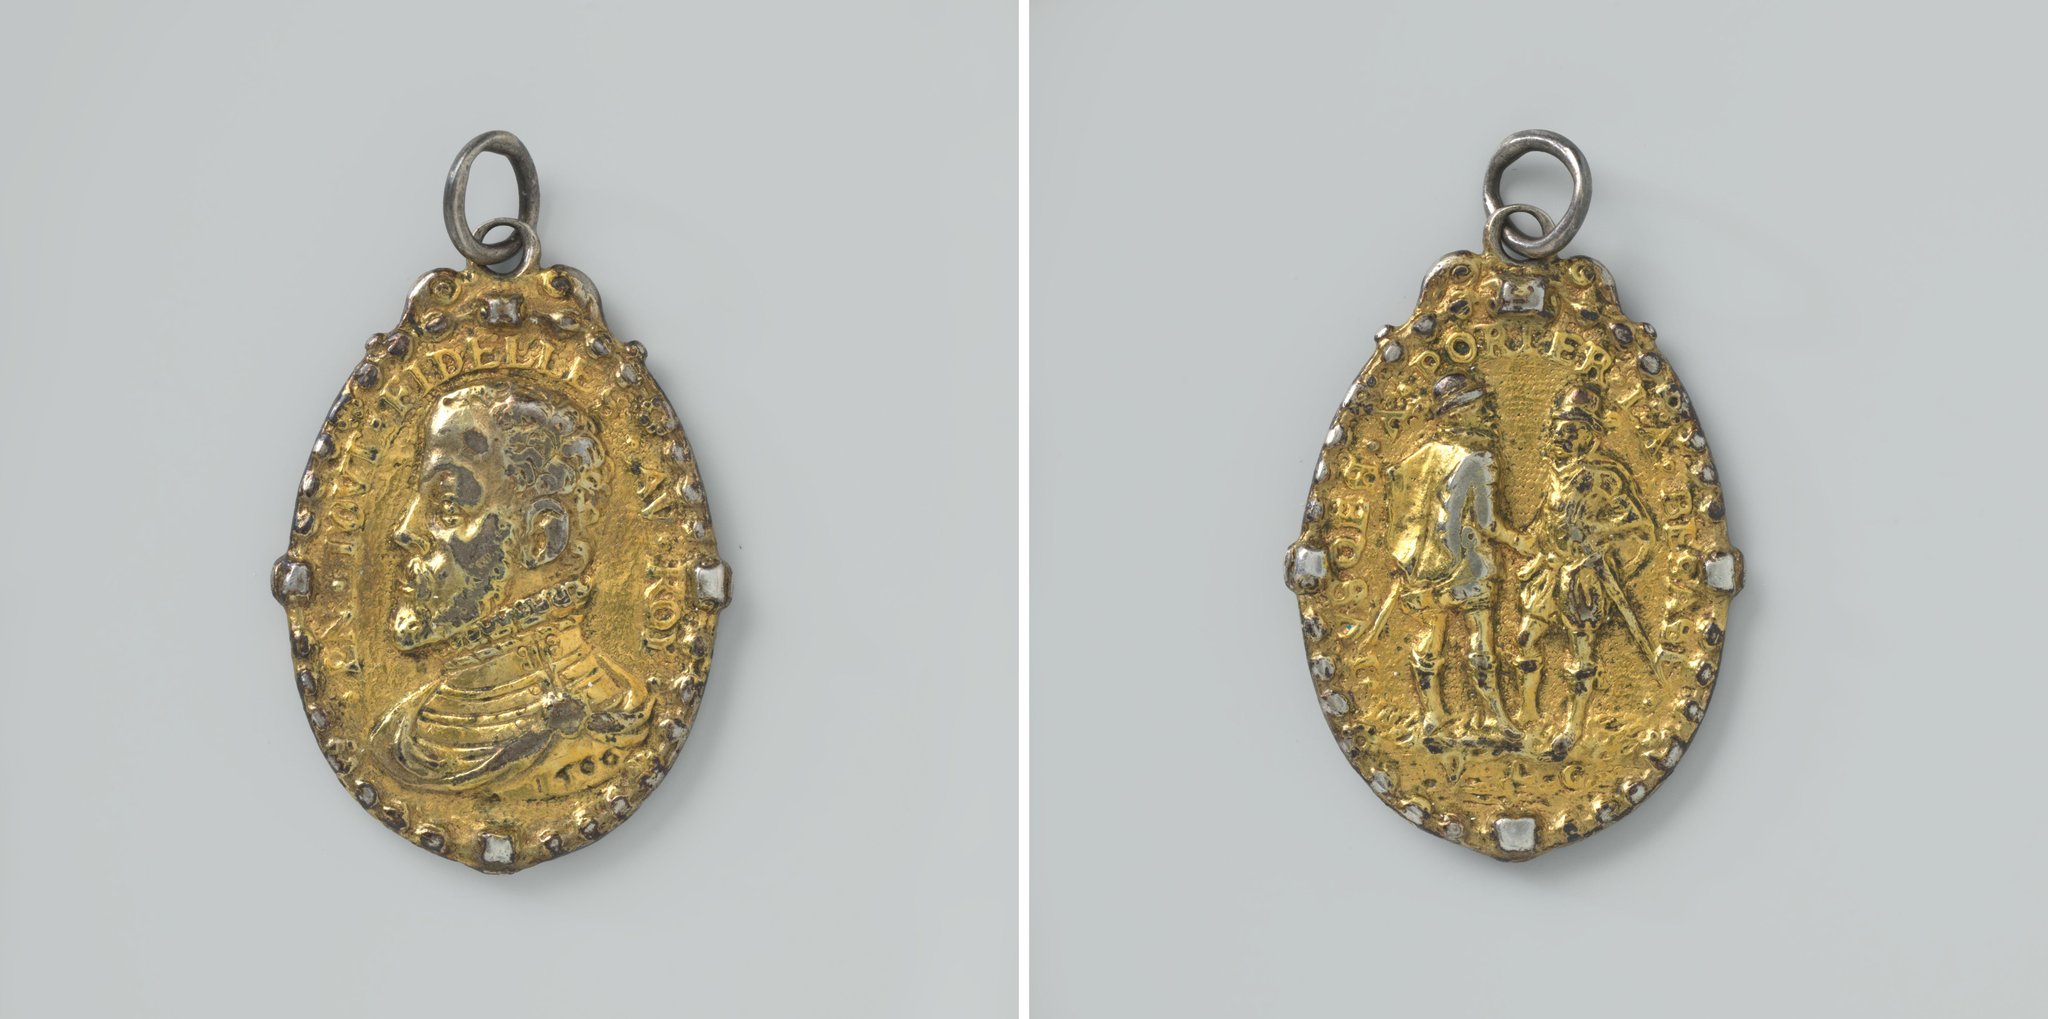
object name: beggar's medal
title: Geuzenpenning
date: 1553-1727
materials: silver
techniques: gilding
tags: philip ii of spain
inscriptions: circumscription: ‘IVSQES.A.PORTER.LA.BESACE’, circumscription: ‘EN.TOVT.FIDELLES.AV.ROY’